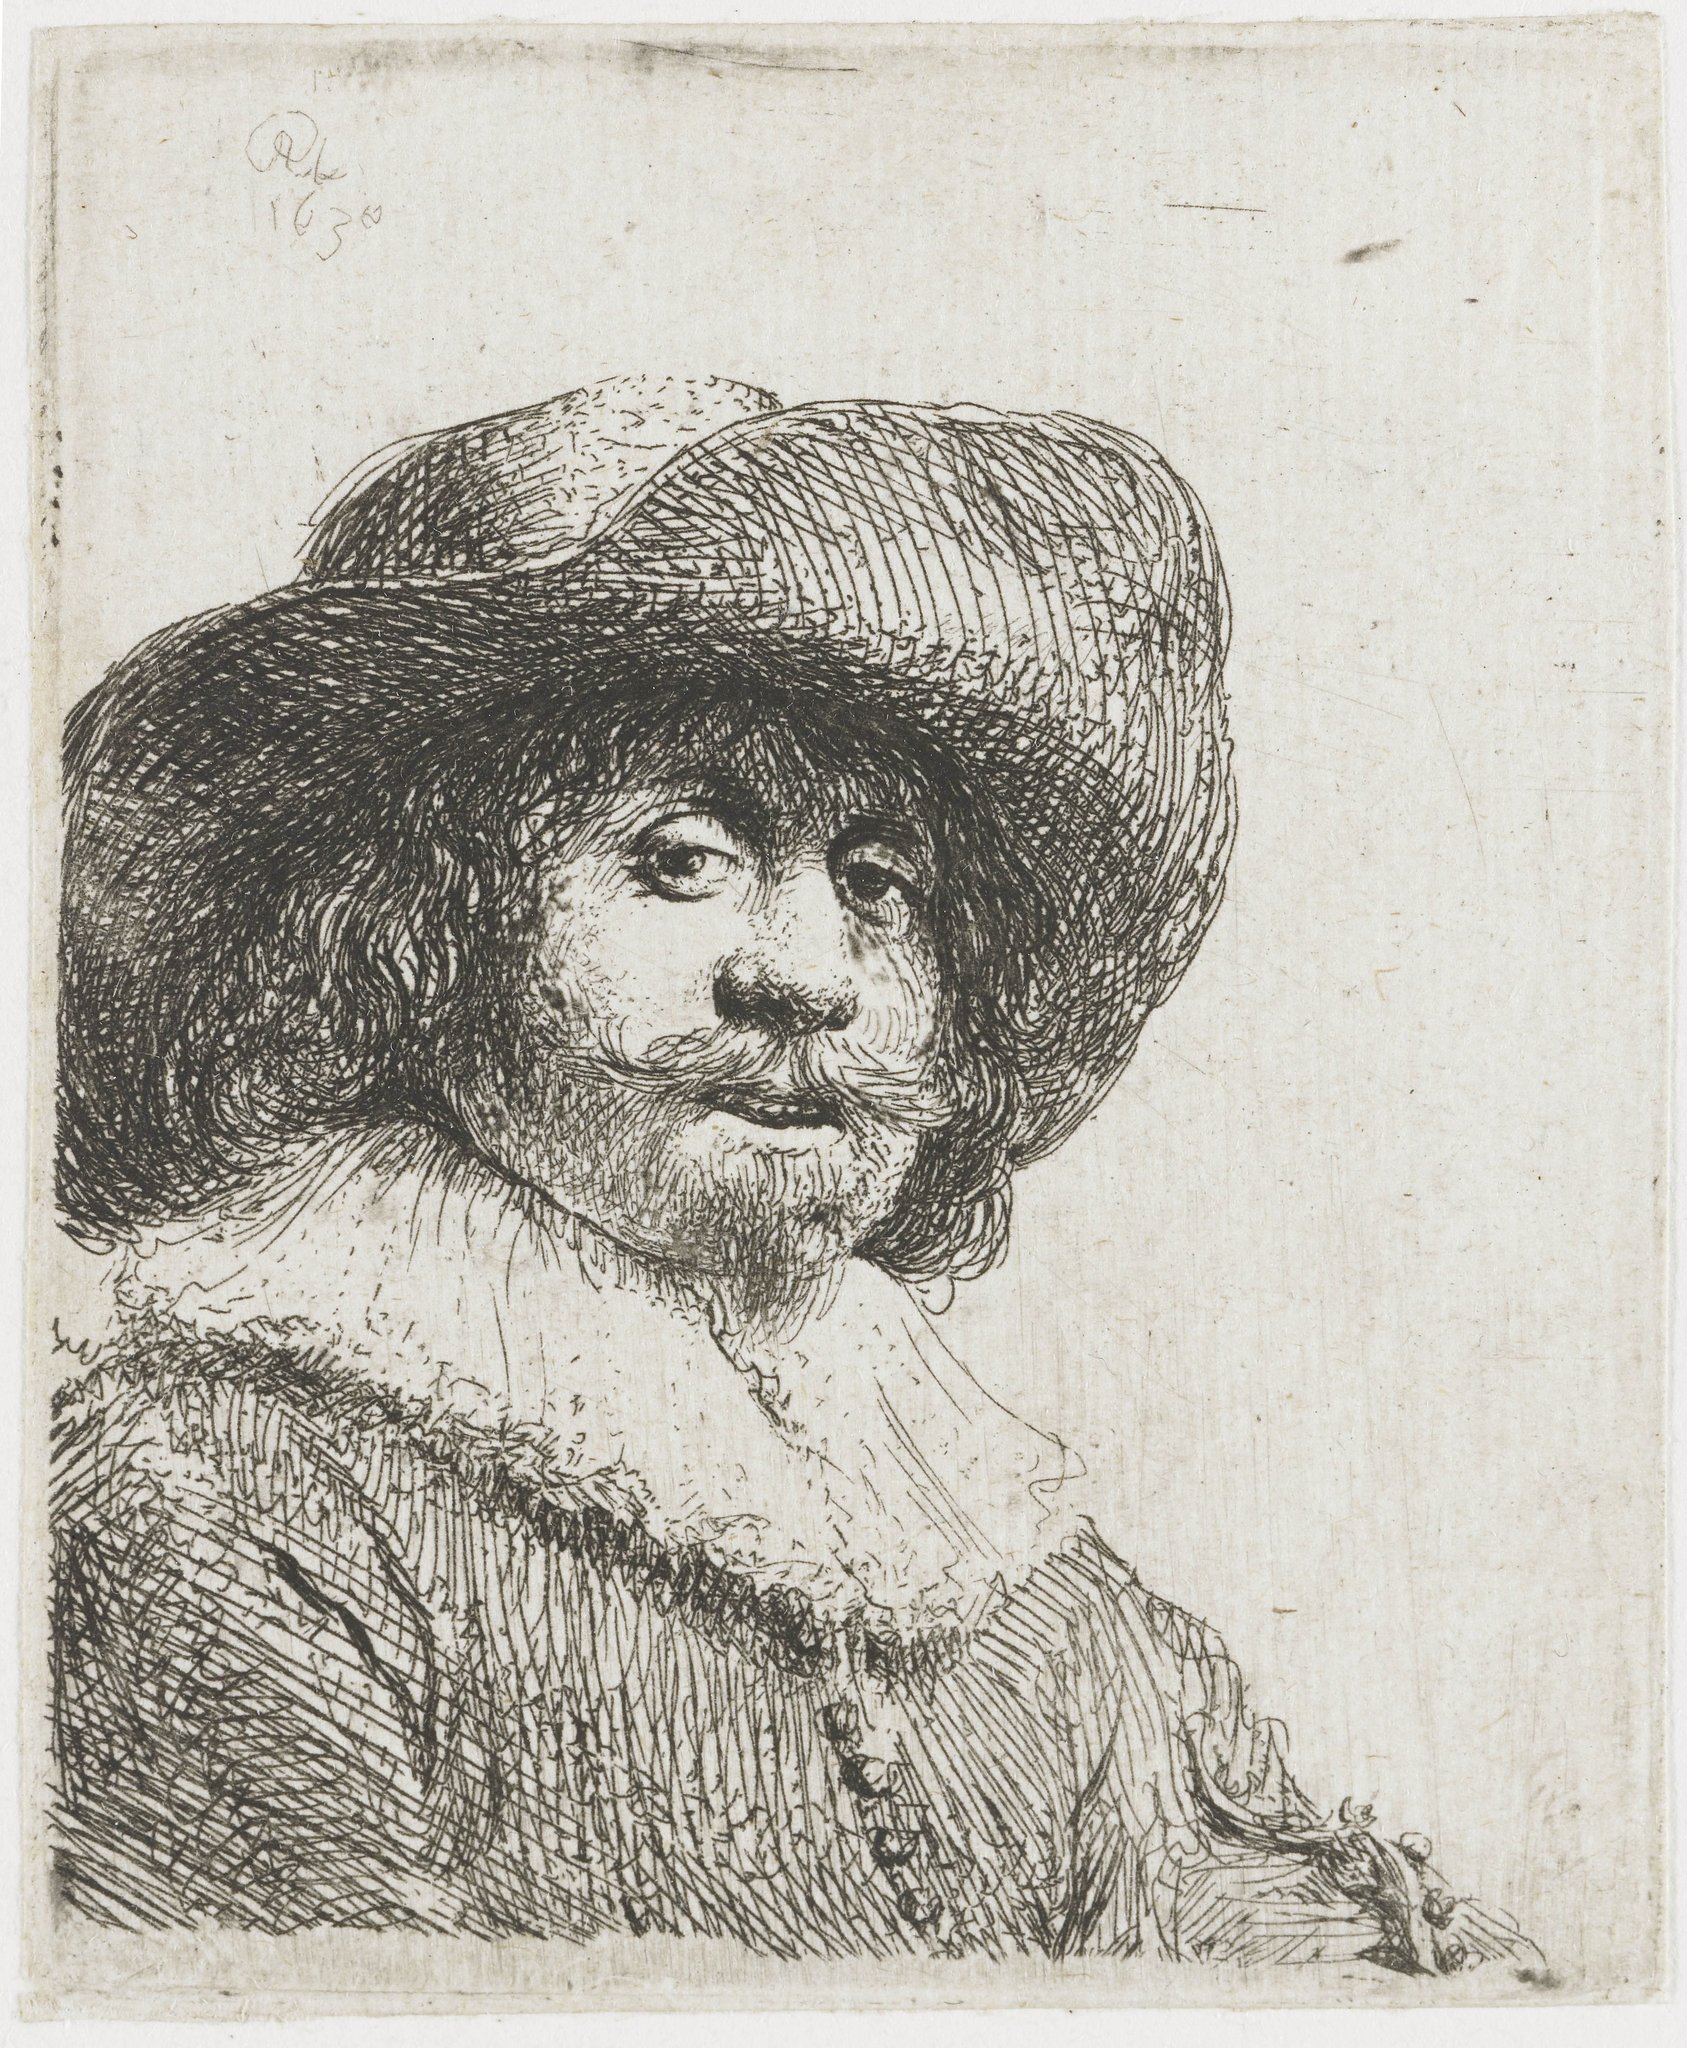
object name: print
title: Man in a broad-brimmed hat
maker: rembrandt van rijn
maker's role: draughtsman, painter, print maker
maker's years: 1606-1669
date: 1630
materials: paper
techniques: etching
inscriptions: collector's mark: Lugt 240, monogram and date: ‘RHL 1638’